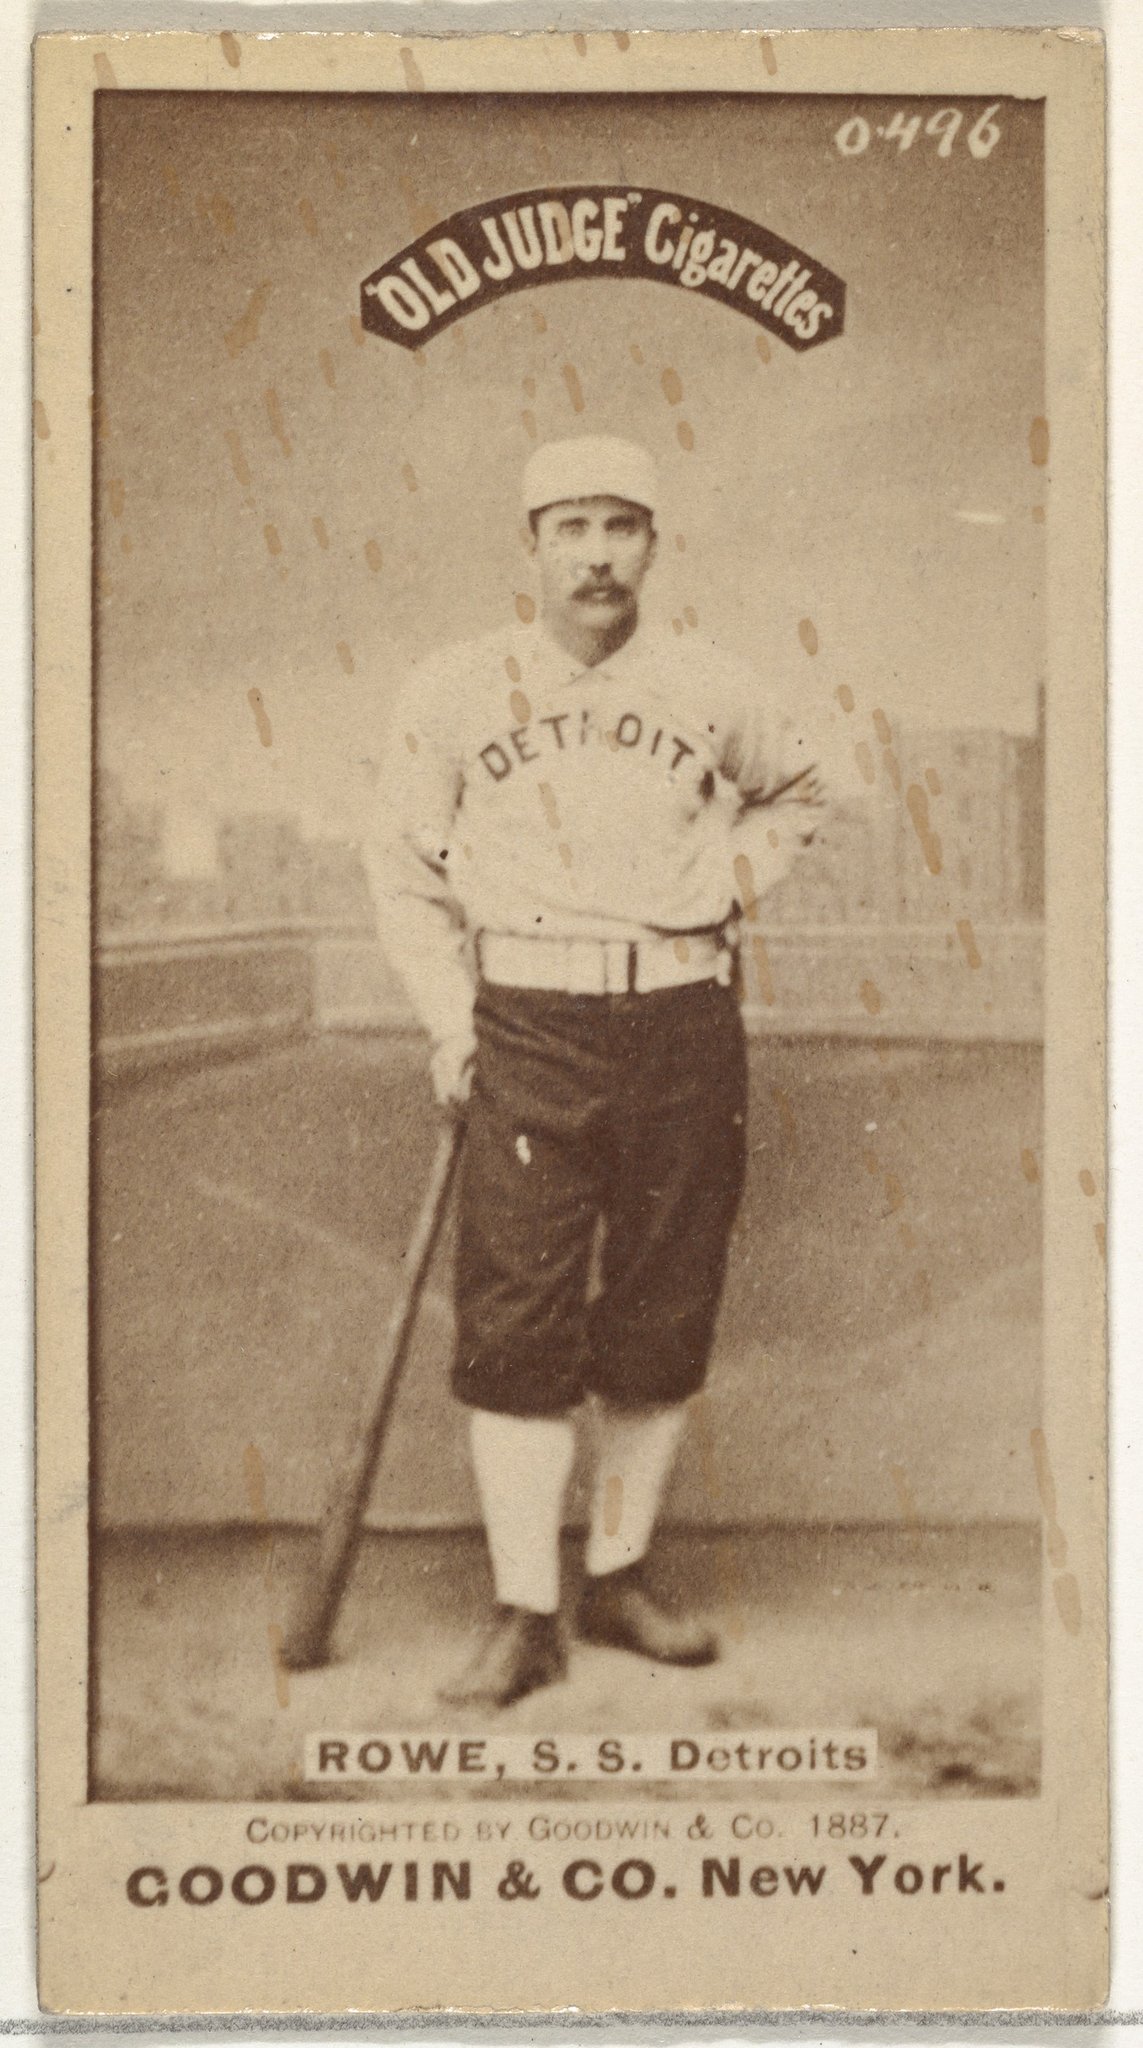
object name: baseball card, photograph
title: John Charles "Jack" Rowe, Shortstop, Detroit Wolverines, from the Old Judge series (N172) for Old Judge Cigarettes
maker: goodwin & company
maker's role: publisher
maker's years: 1850-1950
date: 1887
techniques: albumen silver print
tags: men,portraits,baseball,athletes